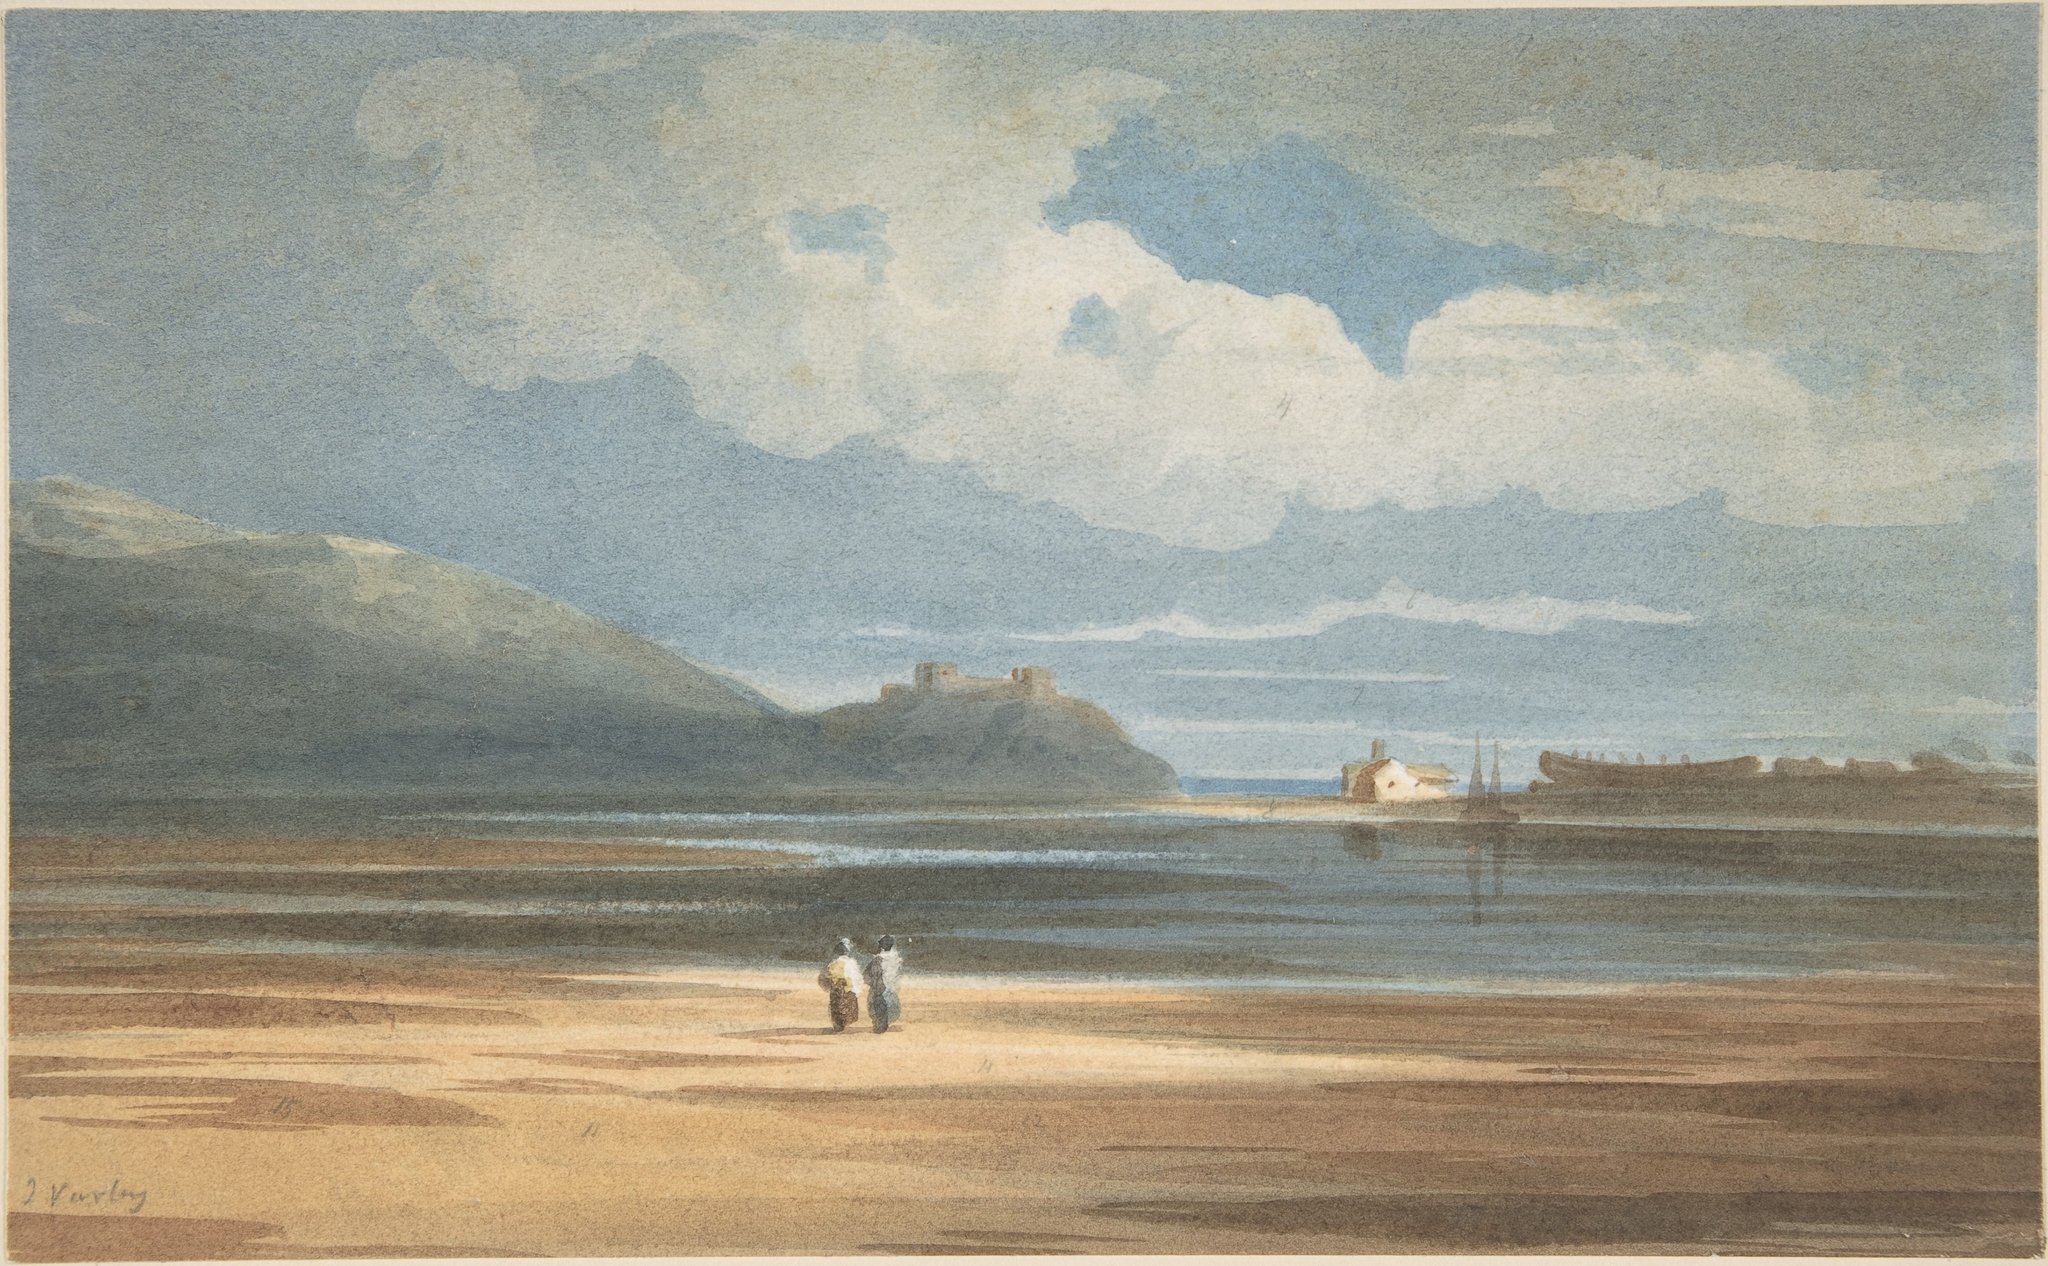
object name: drawing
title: Harlech Castle across the Traeth Mawr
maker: john varley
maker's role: artist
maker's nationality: british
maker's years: 1778-1842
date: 1800-1842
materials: graphite, watercolor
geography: united kingdom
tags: castles,landscapes,boats